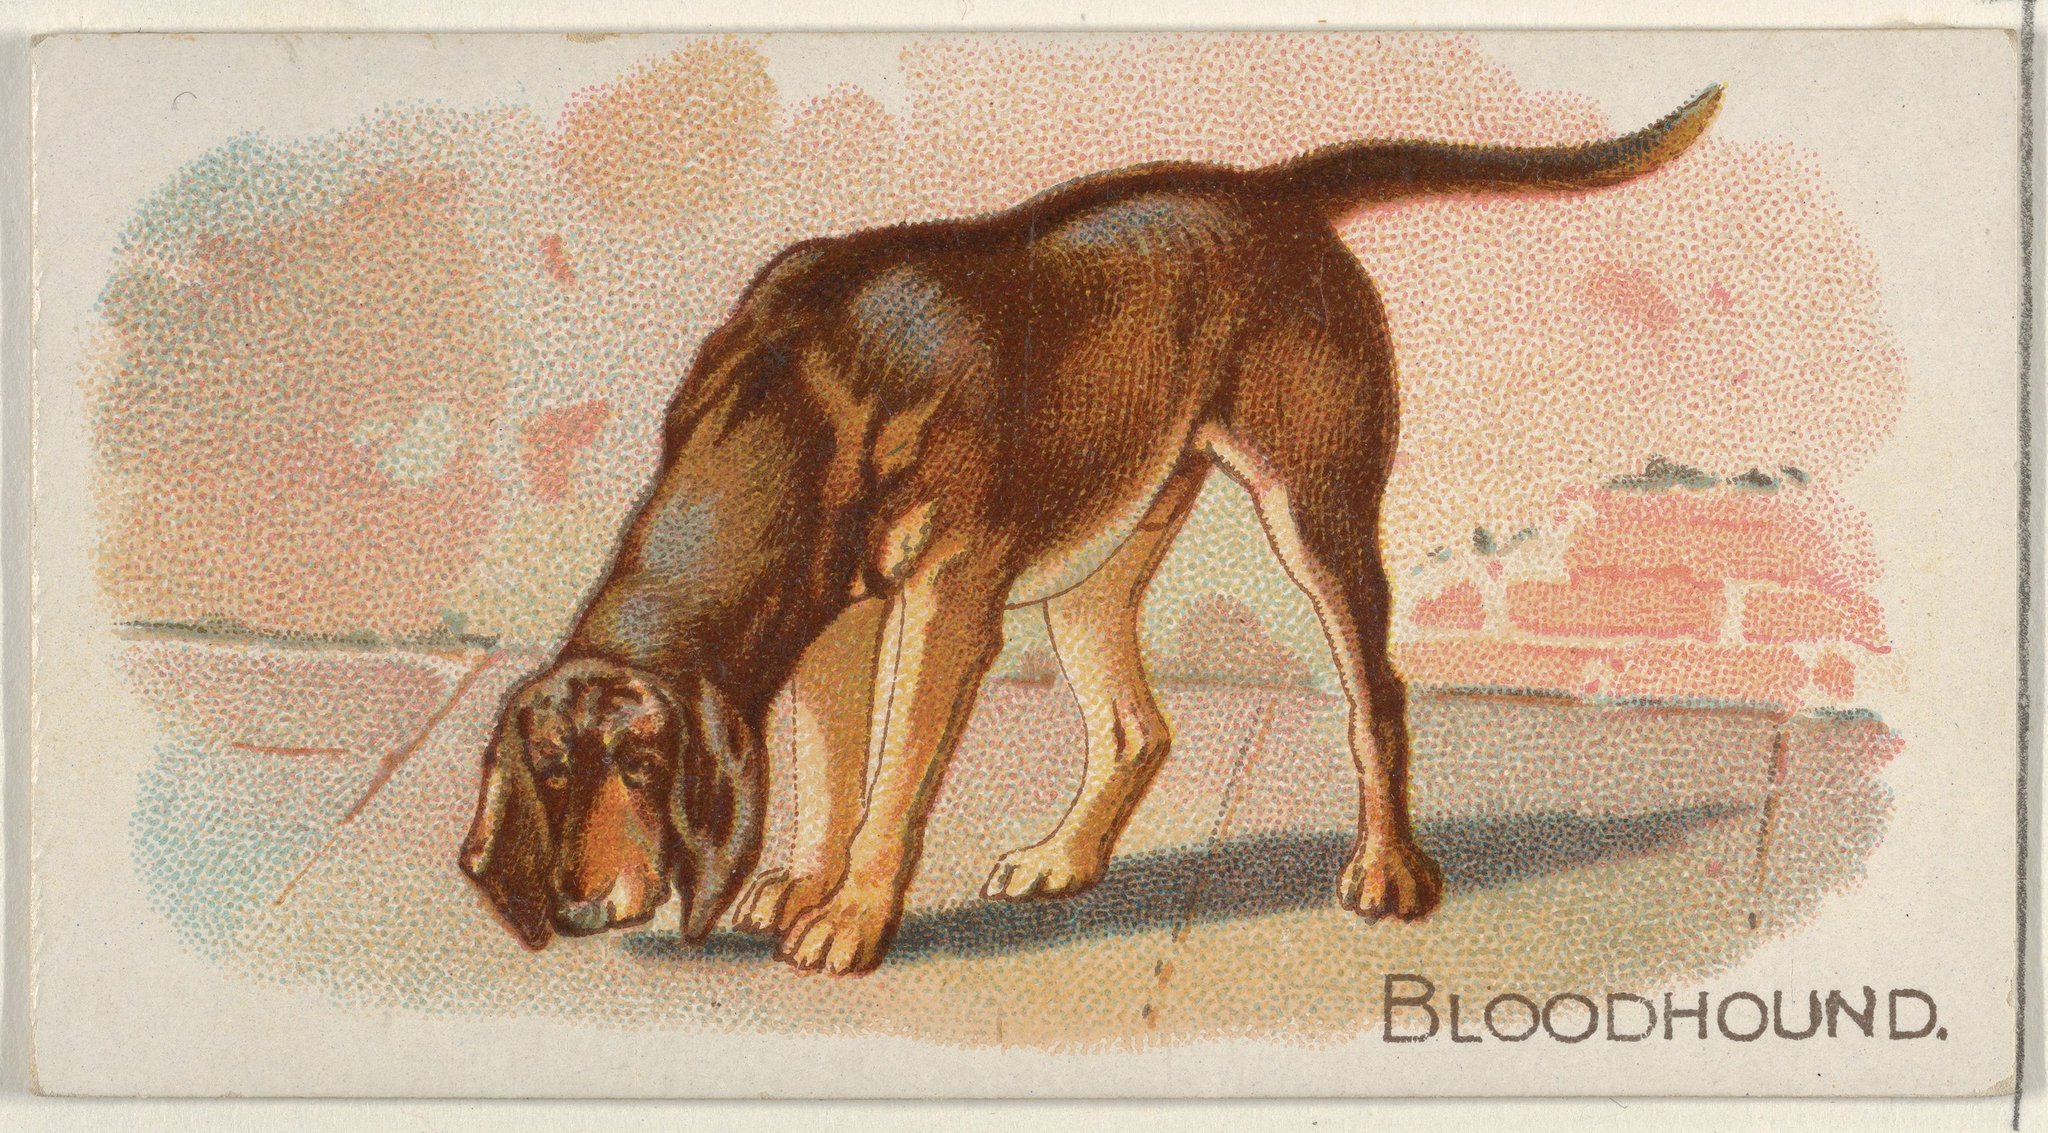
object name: print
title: Bloodhound, from the Quadrupeds series (N21) for Allen & Ginter Cigarettes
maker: allen & ginter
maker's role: publisher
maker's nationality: american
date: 1890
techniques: color lithograph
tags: dogs